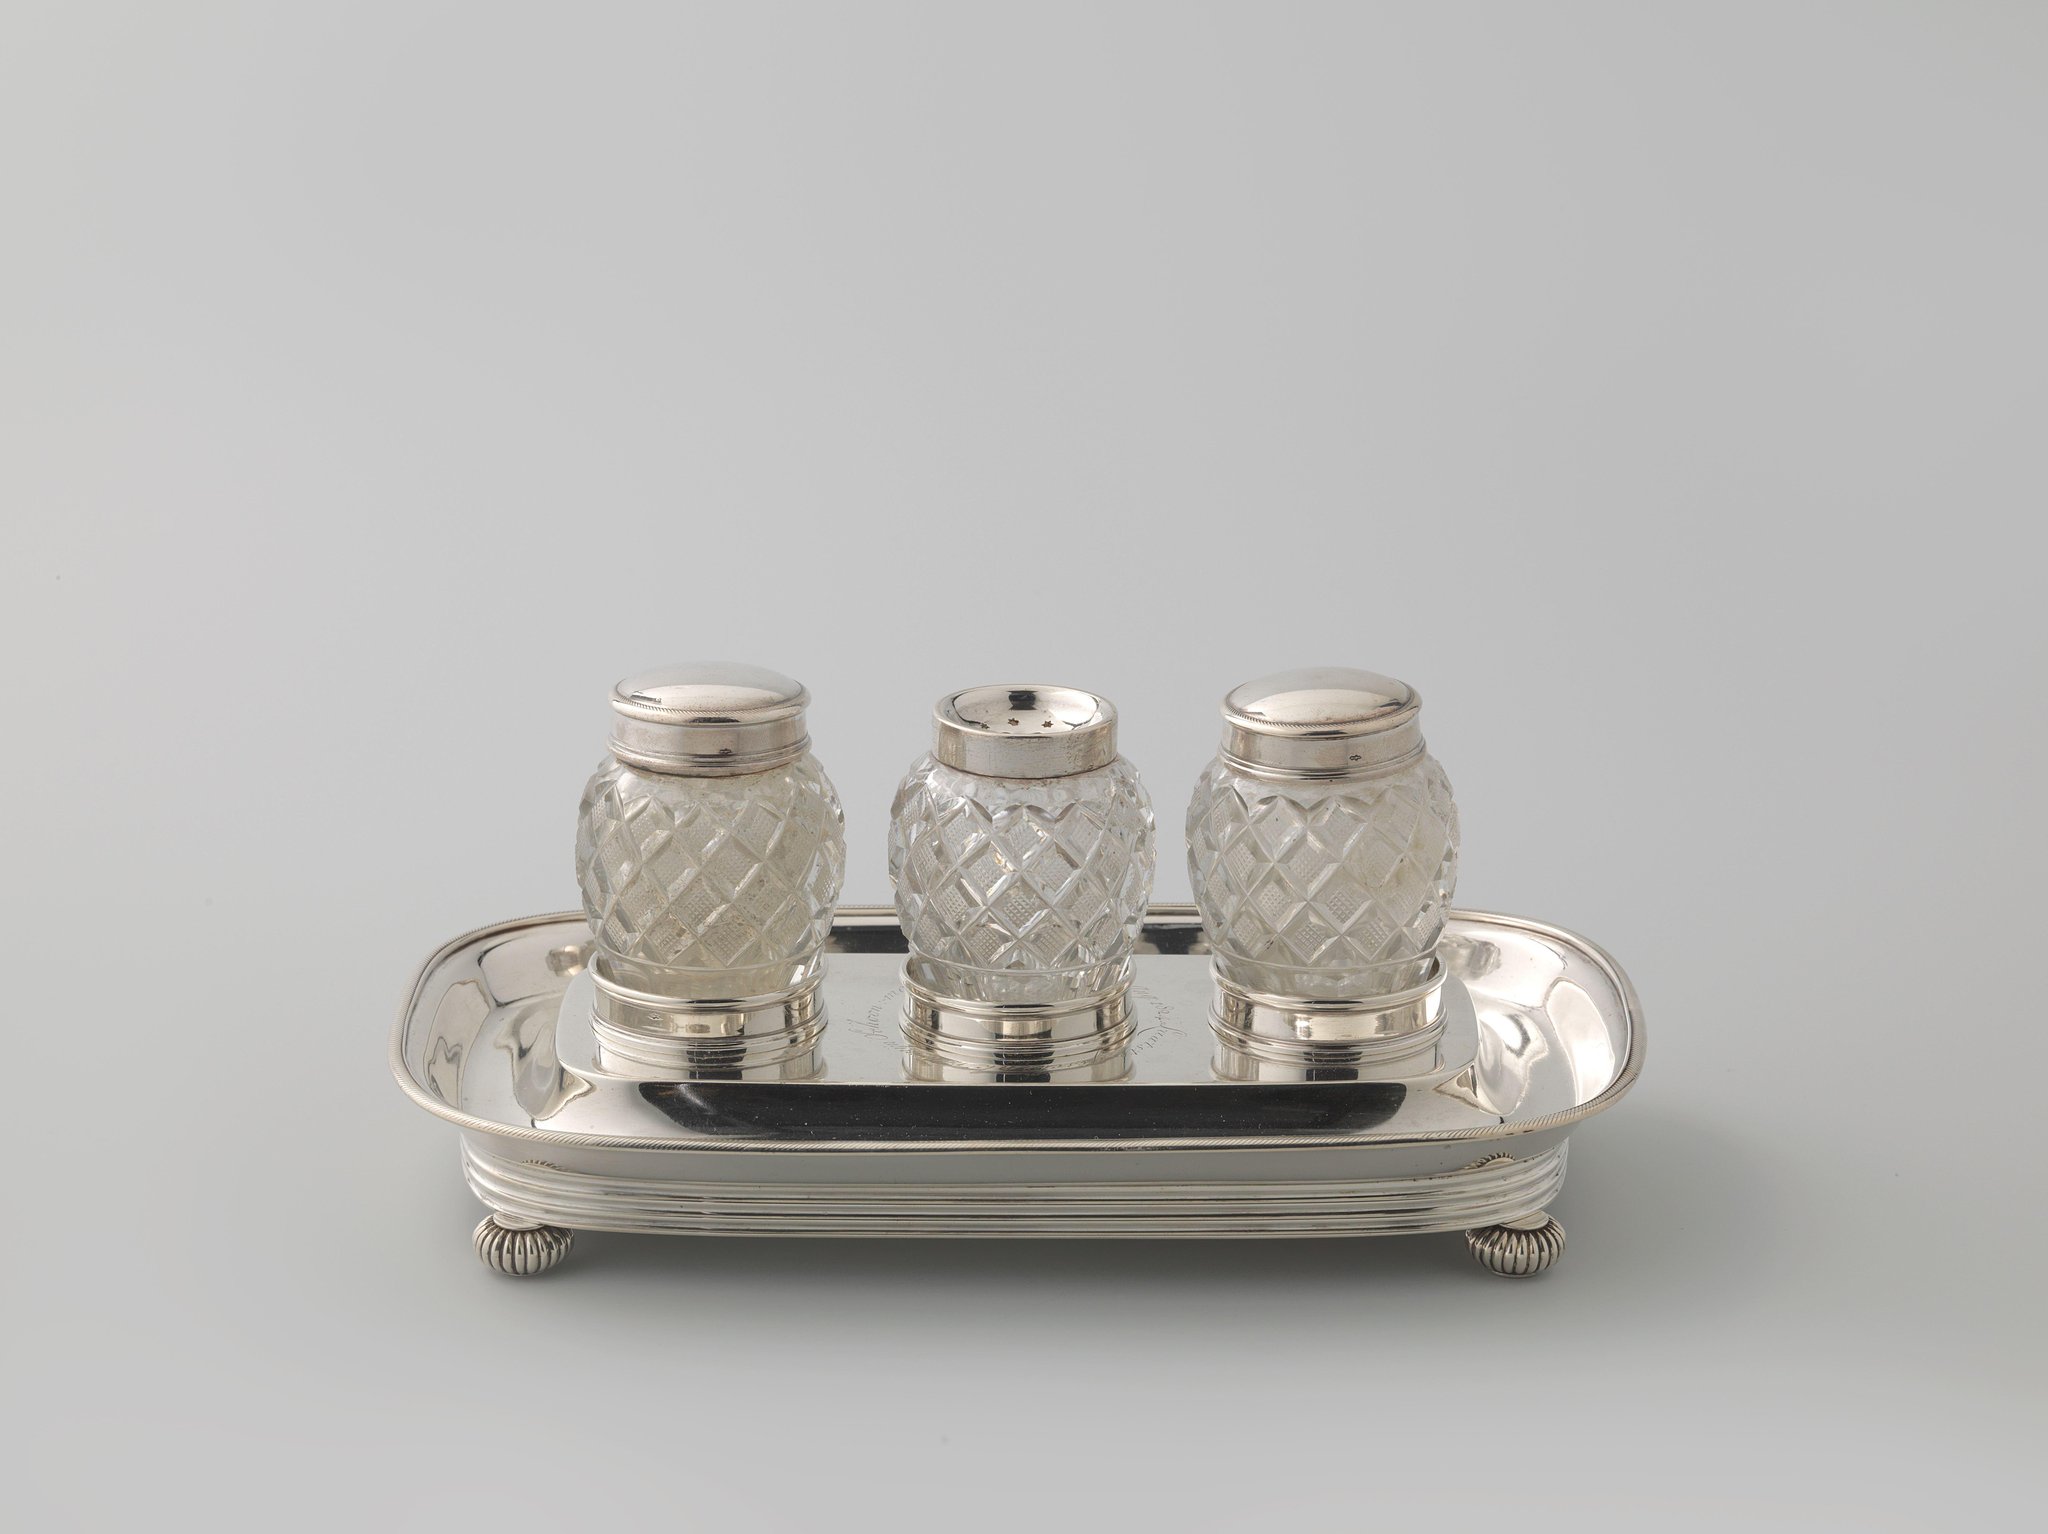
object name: inkstand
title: Pot van inktstel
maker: theodorus gerardus bentvelt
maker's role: silversmith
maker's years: 1782-1853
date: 1824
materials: glass, silver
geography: amsterdam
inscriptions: assay office mark, alloy mark, maker's mark, date letter: ‘P’, hallmark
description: Tonvormige pot van kleurloos glas, versierd met een geslepen ruitpatroon. Op de hals is een gladde, zilveren ring gemonteerd, waarop een zilveren deksel past. Dit heeft een rechte wand met aan de onderzijde een profielrand en aan de bovenzijde een kabelrand, en een licht gewelfde bovenzijde. Bestemd voor inkt. De drie houders zijn door middel van een lange pin onder de bodem van het blad vastgezet.